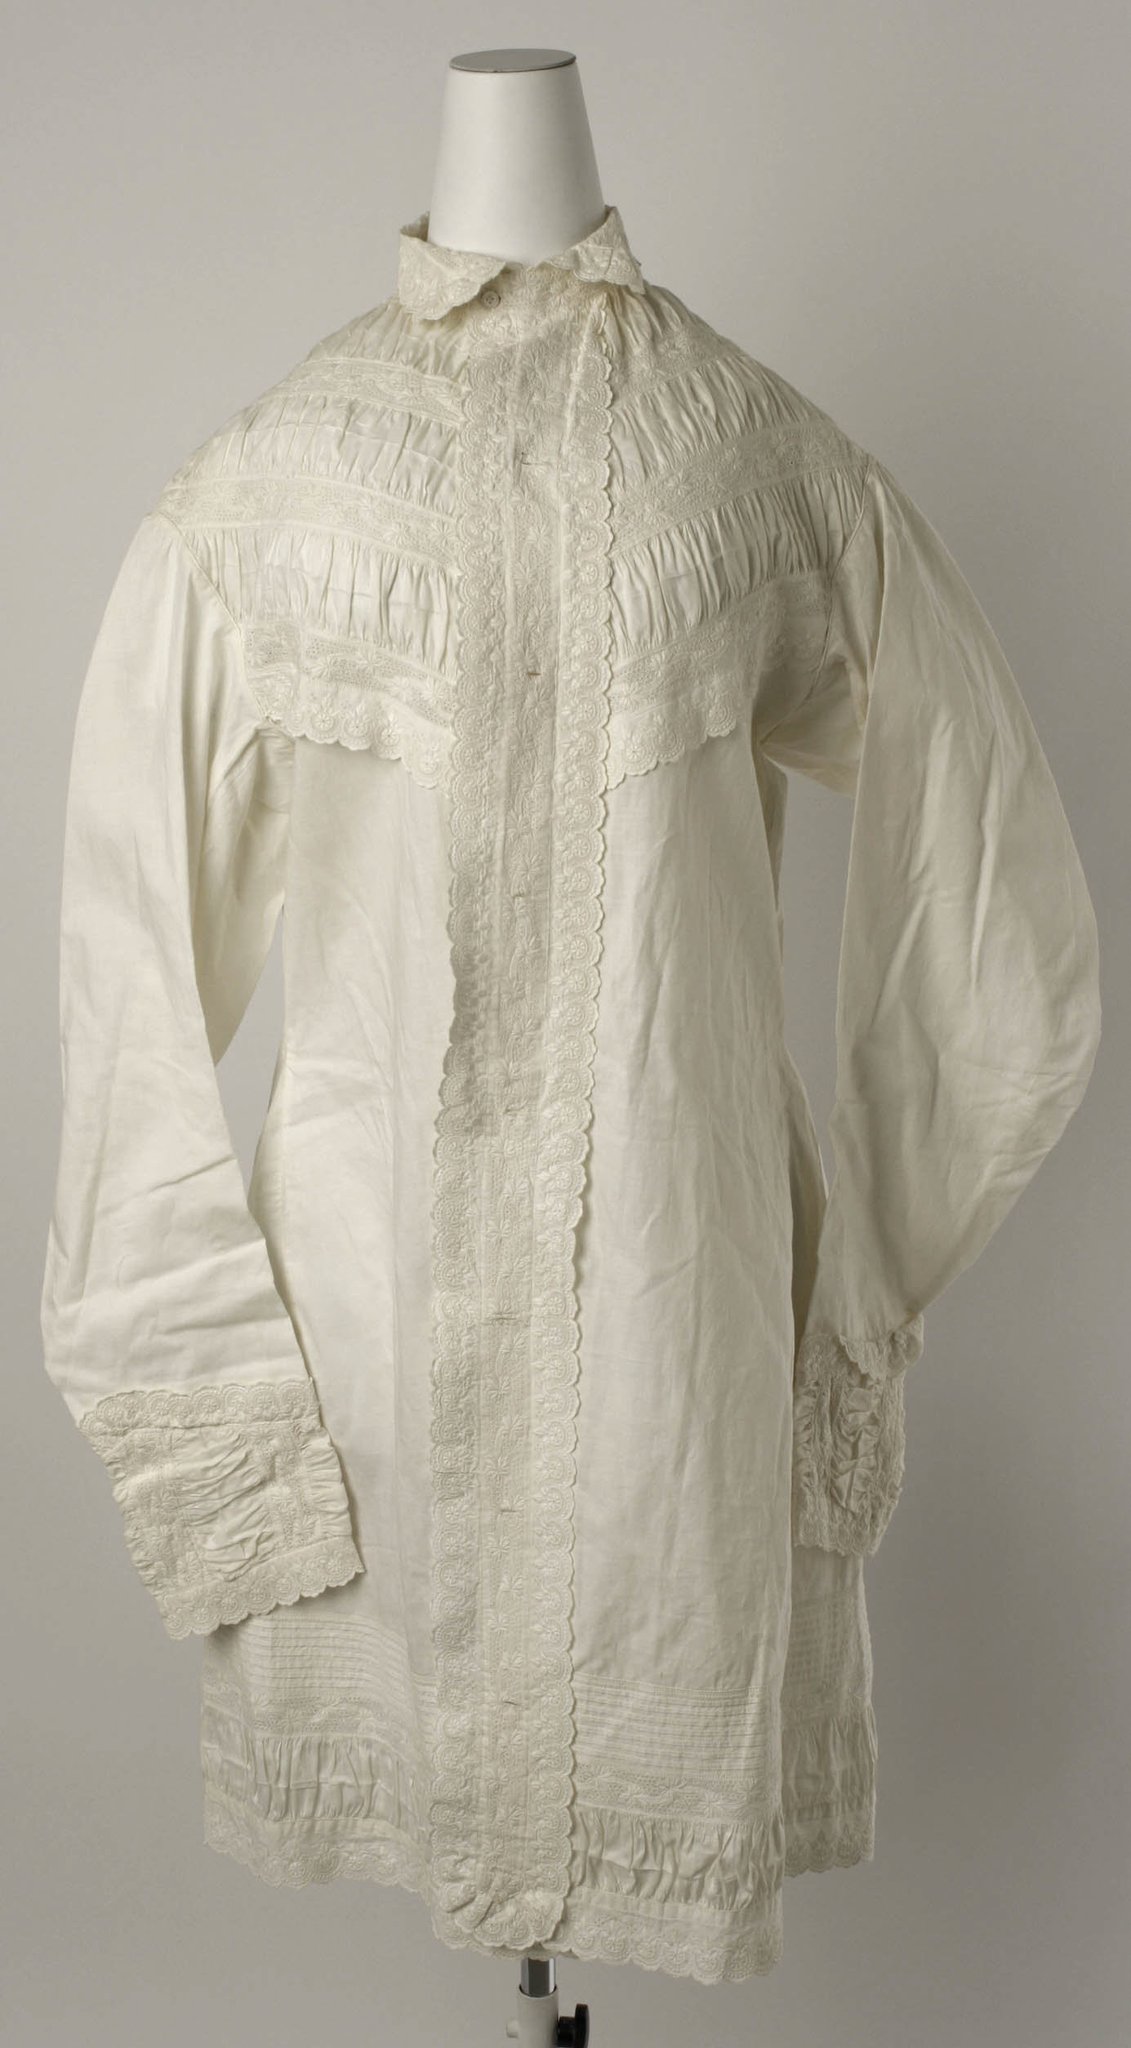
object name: lingerie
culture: american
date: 1876-1885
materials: cotton